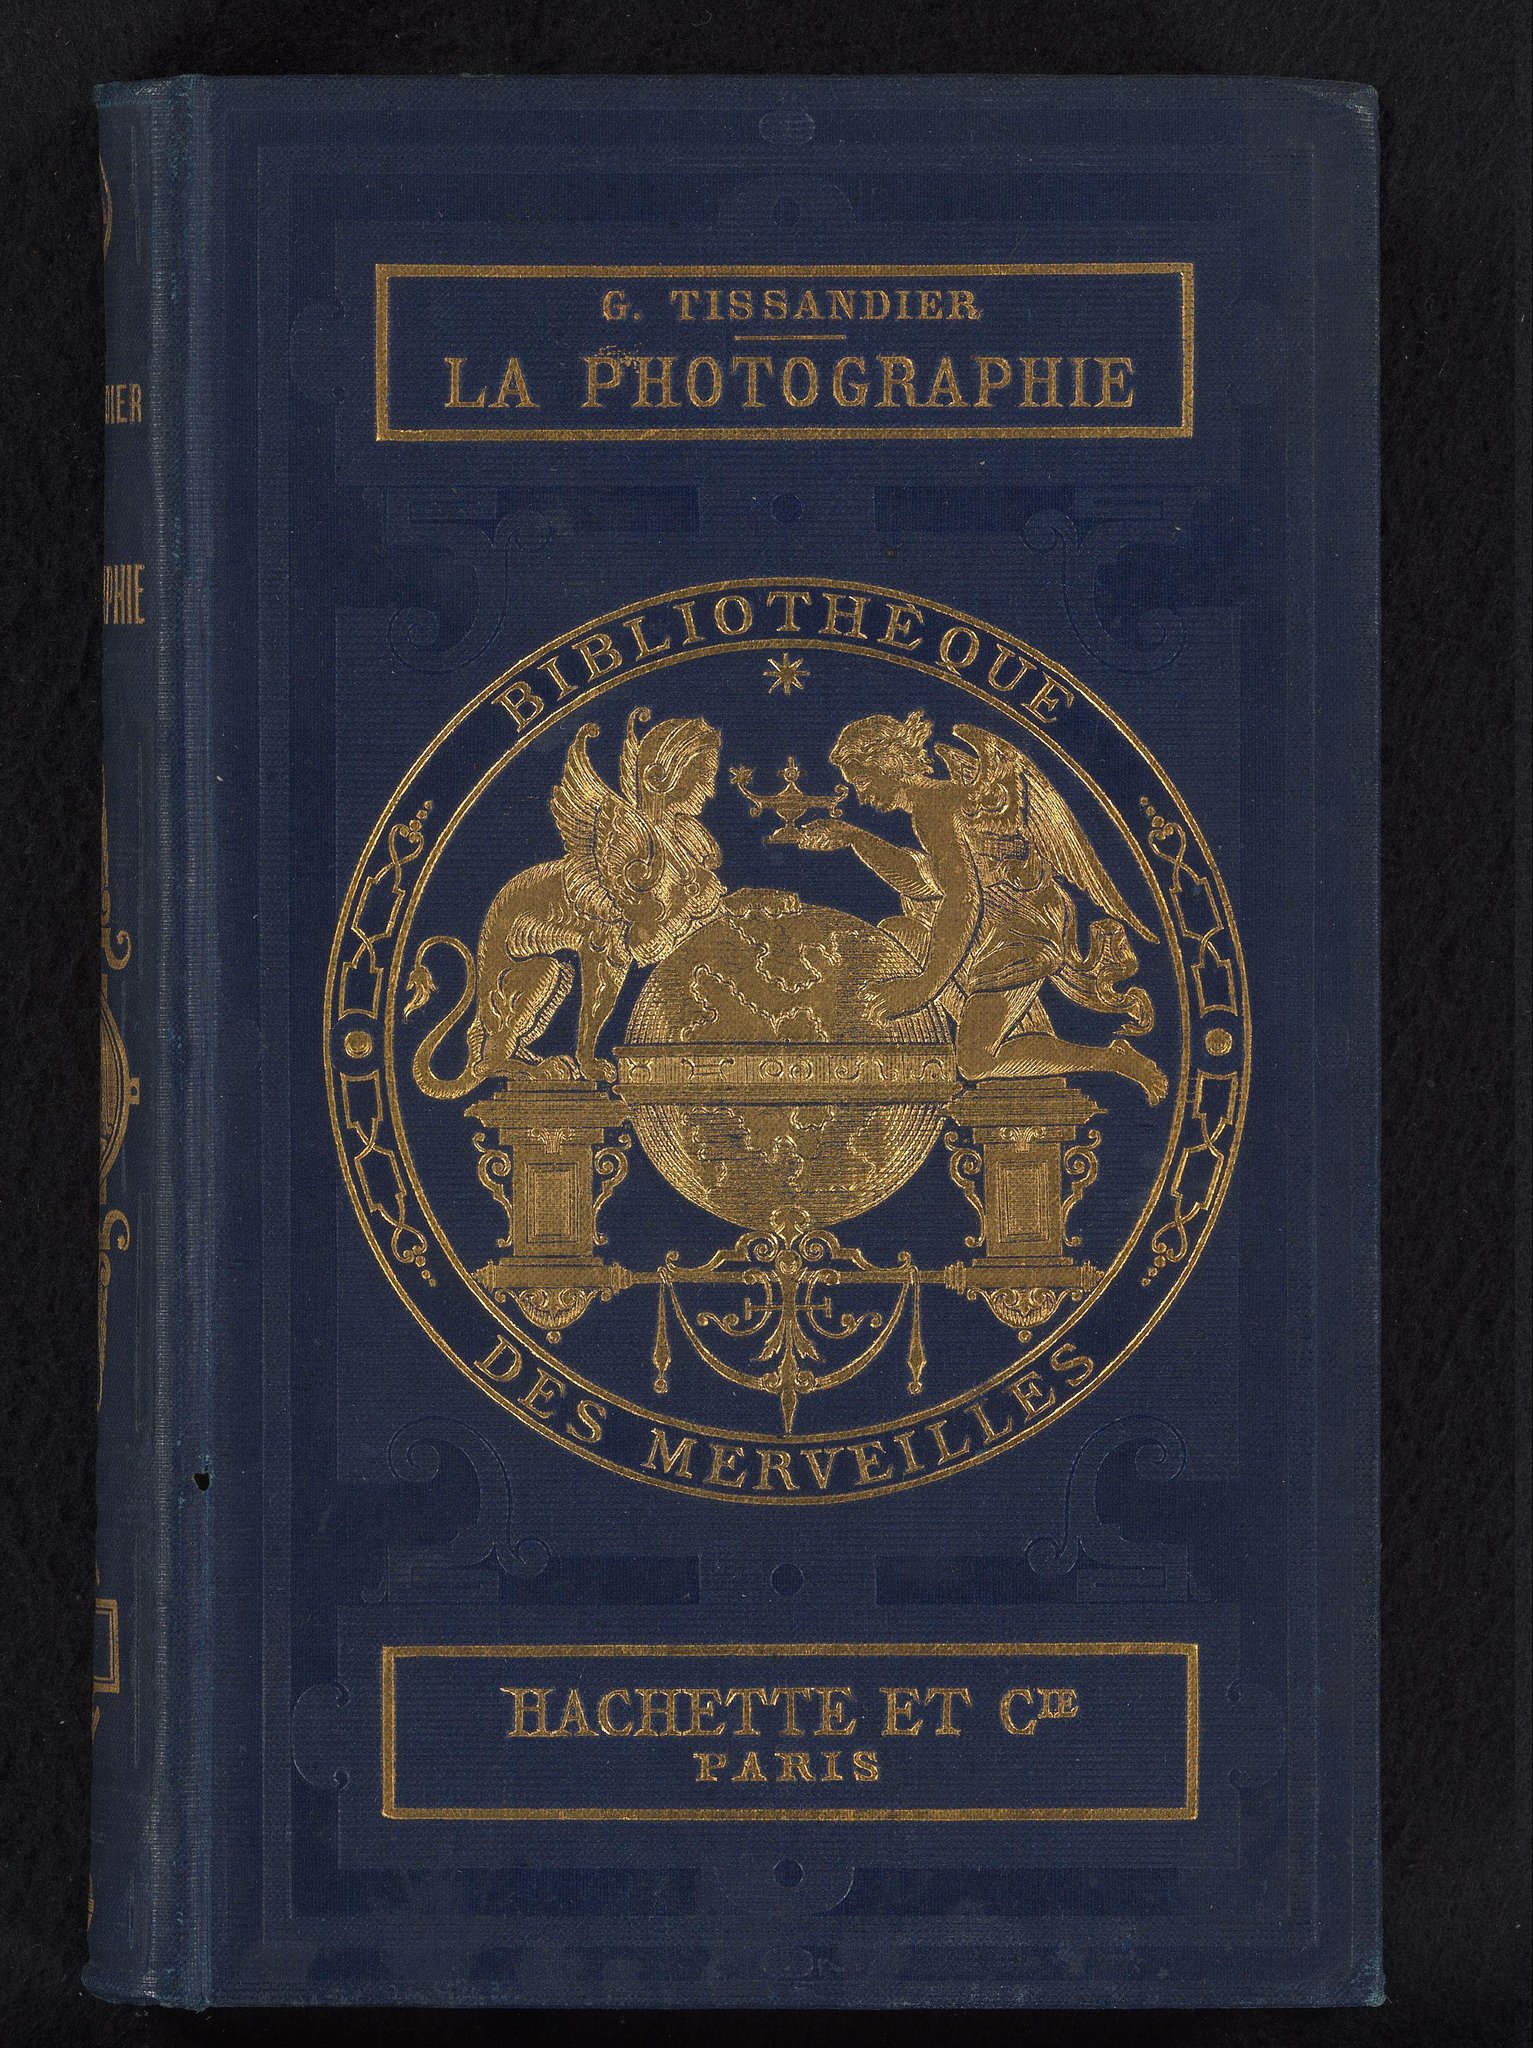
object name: book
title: Les merveilles de la photographie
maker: gaston tissandier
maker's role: fotograaf, scheikundige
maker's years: 1843-1899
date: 1874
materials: cardboard, paper, textile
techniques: printing, woodburytype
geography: paris